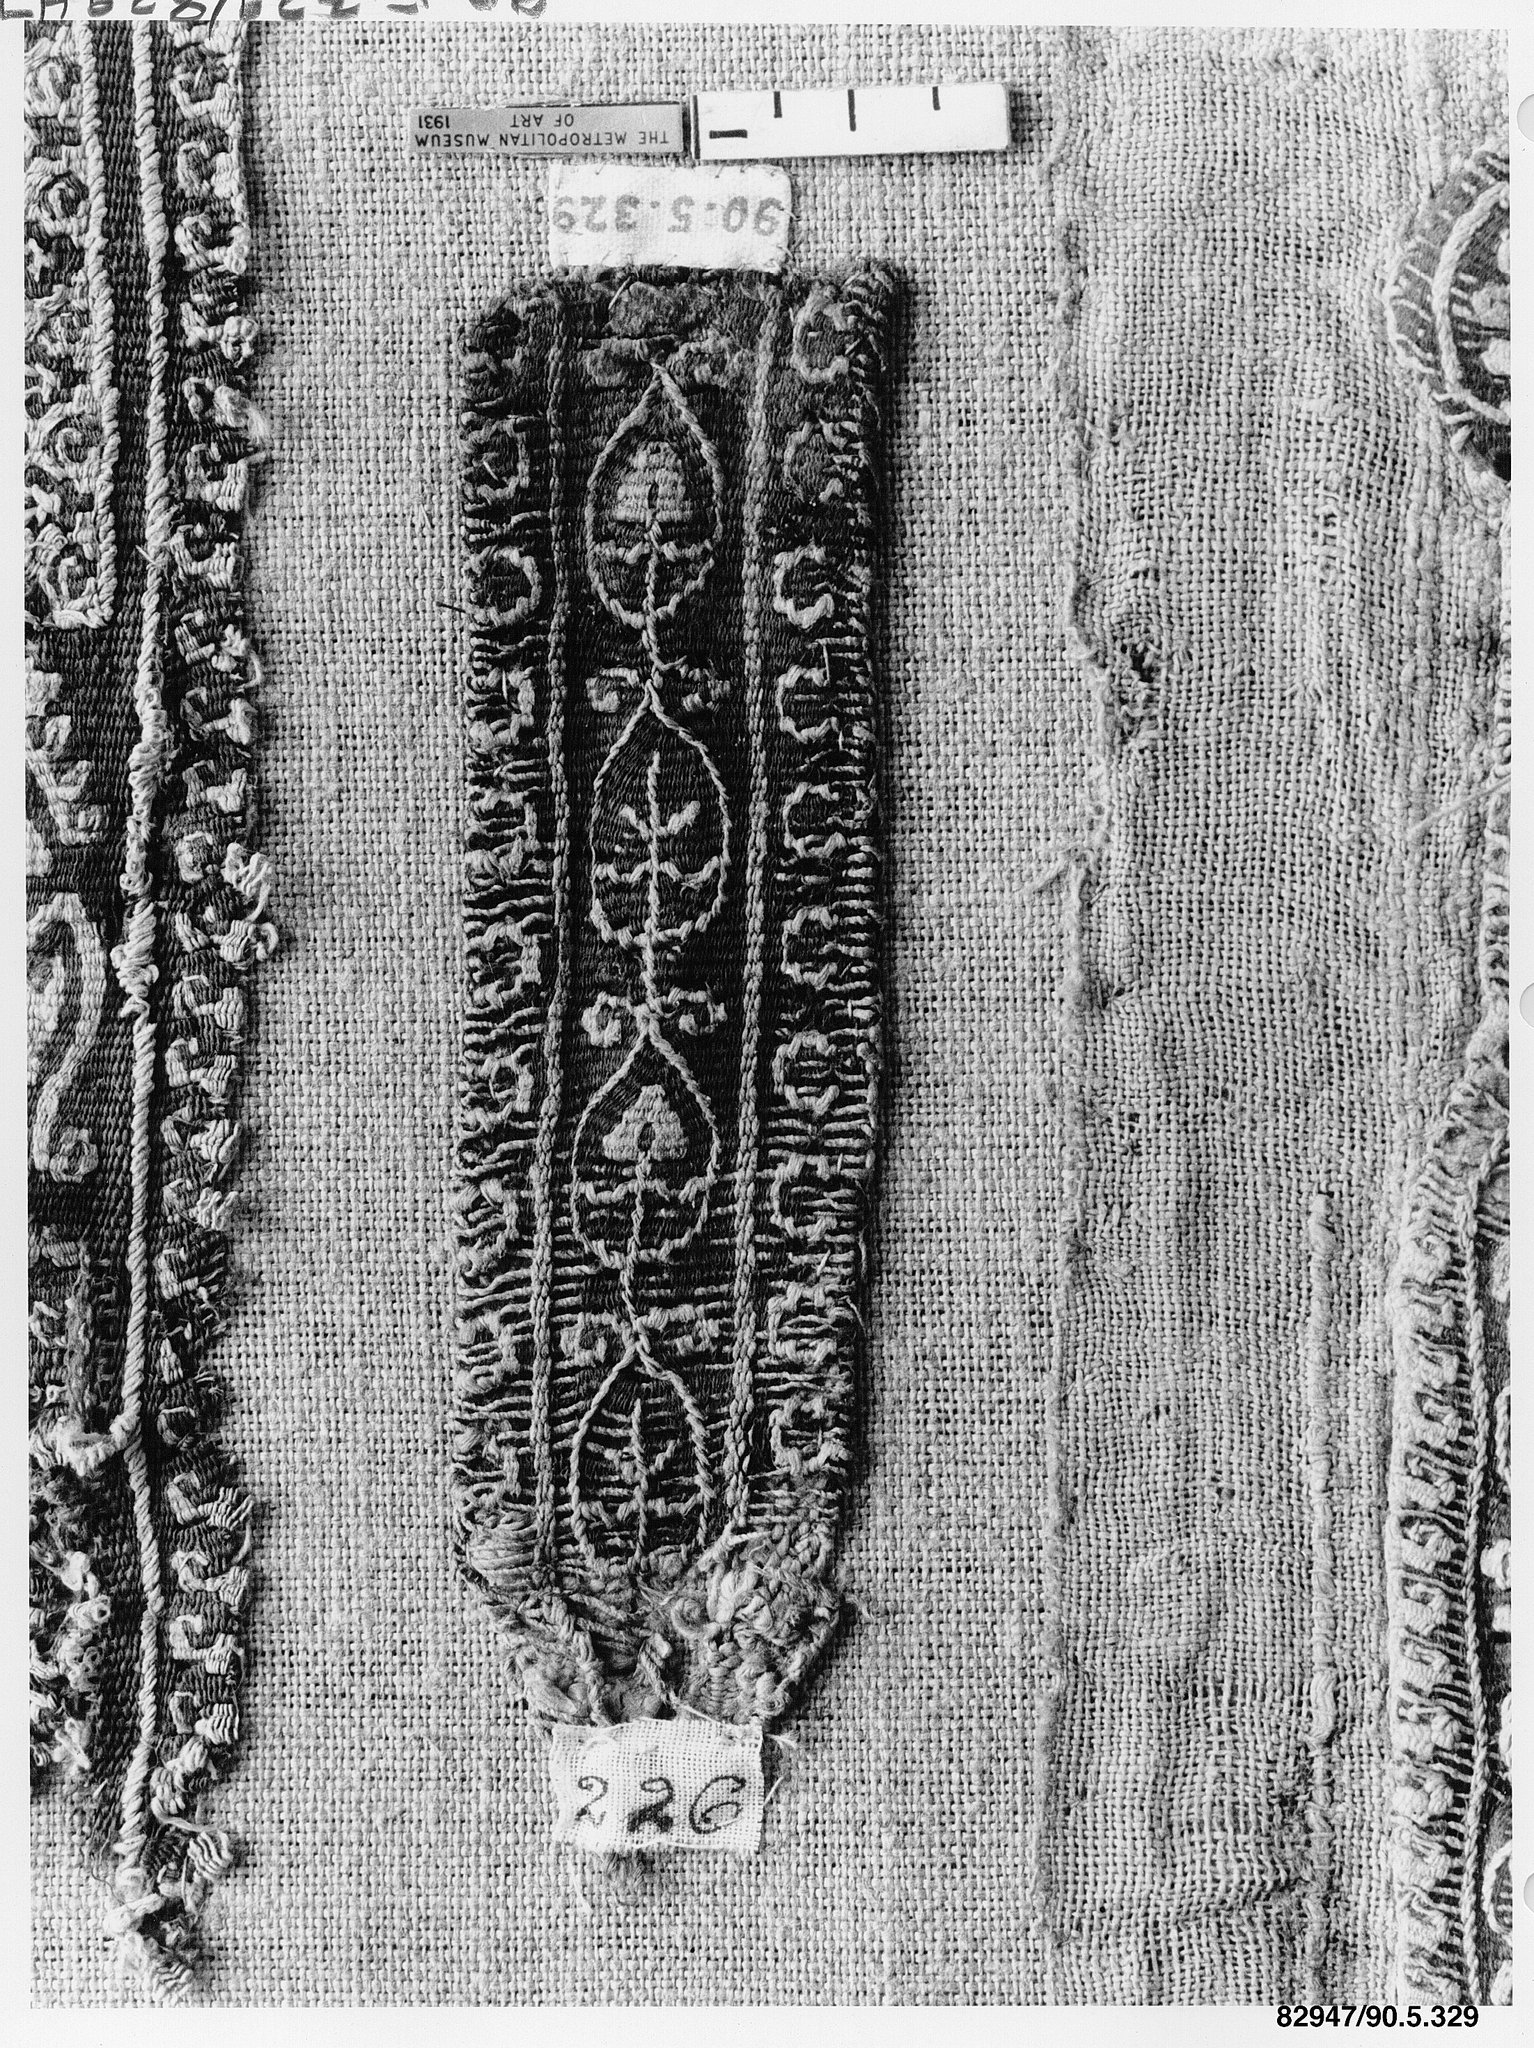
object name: textile fragment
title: Fragment of a Shoulder Band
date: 401-500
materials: linen, wool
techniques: weave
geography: egypt